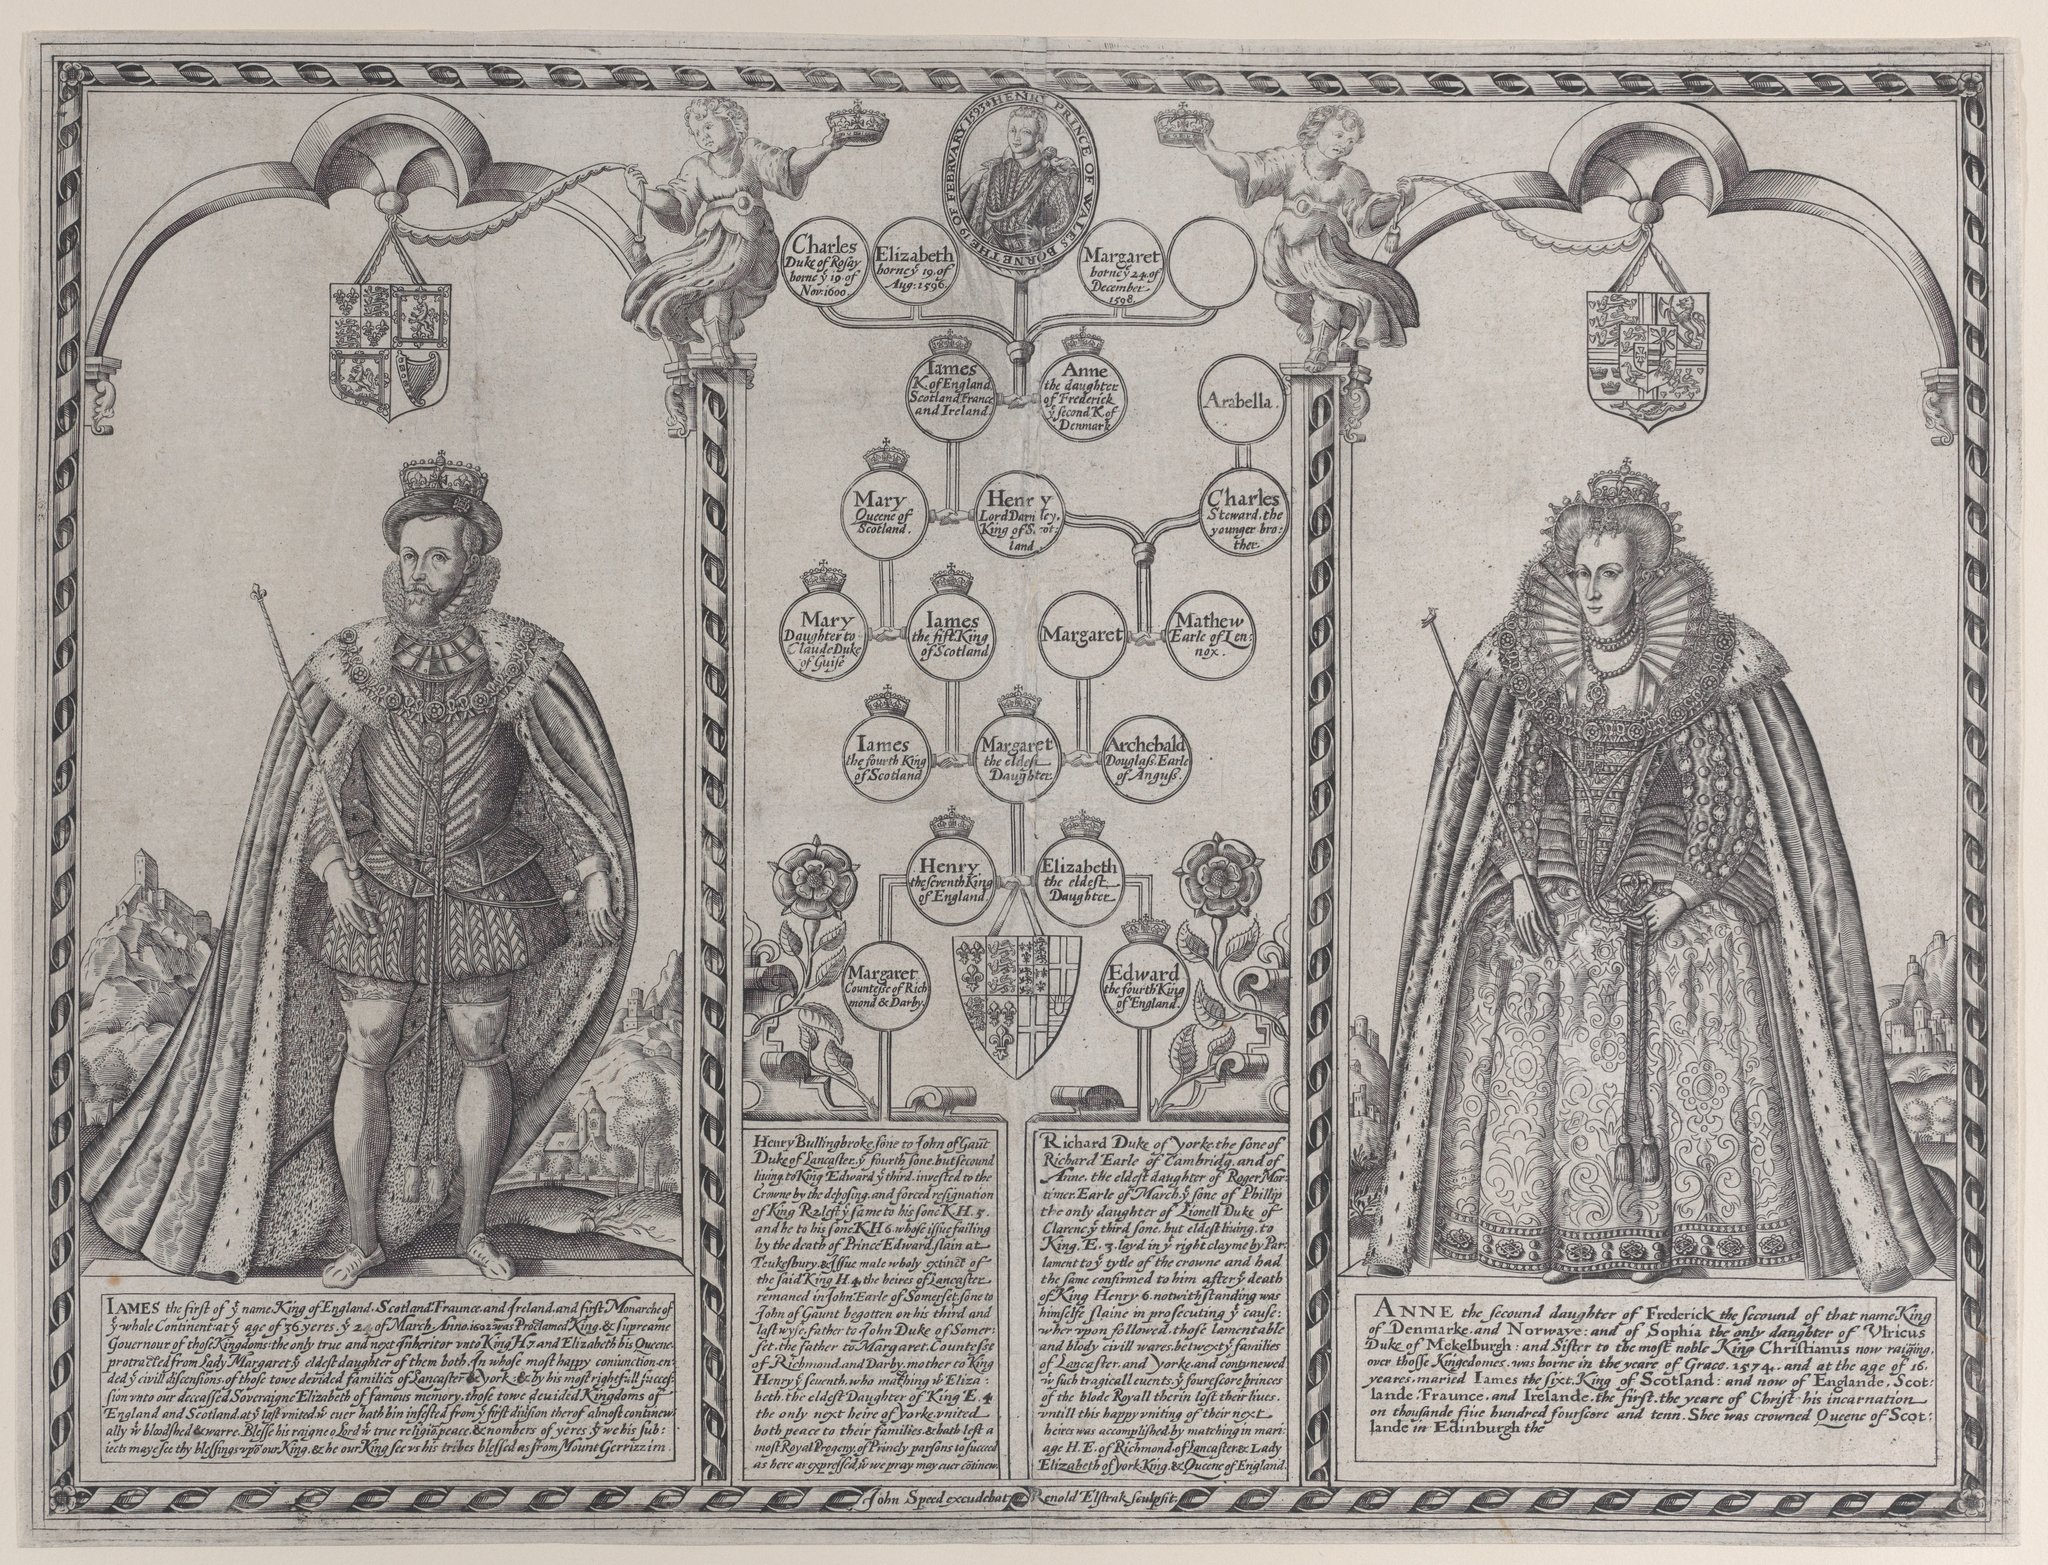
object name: print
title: James I and Anne of Denmark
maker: renold elstrack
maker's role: engraver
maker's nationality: british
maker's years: 1570-1625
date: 1651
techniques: engraving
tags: portraits,women